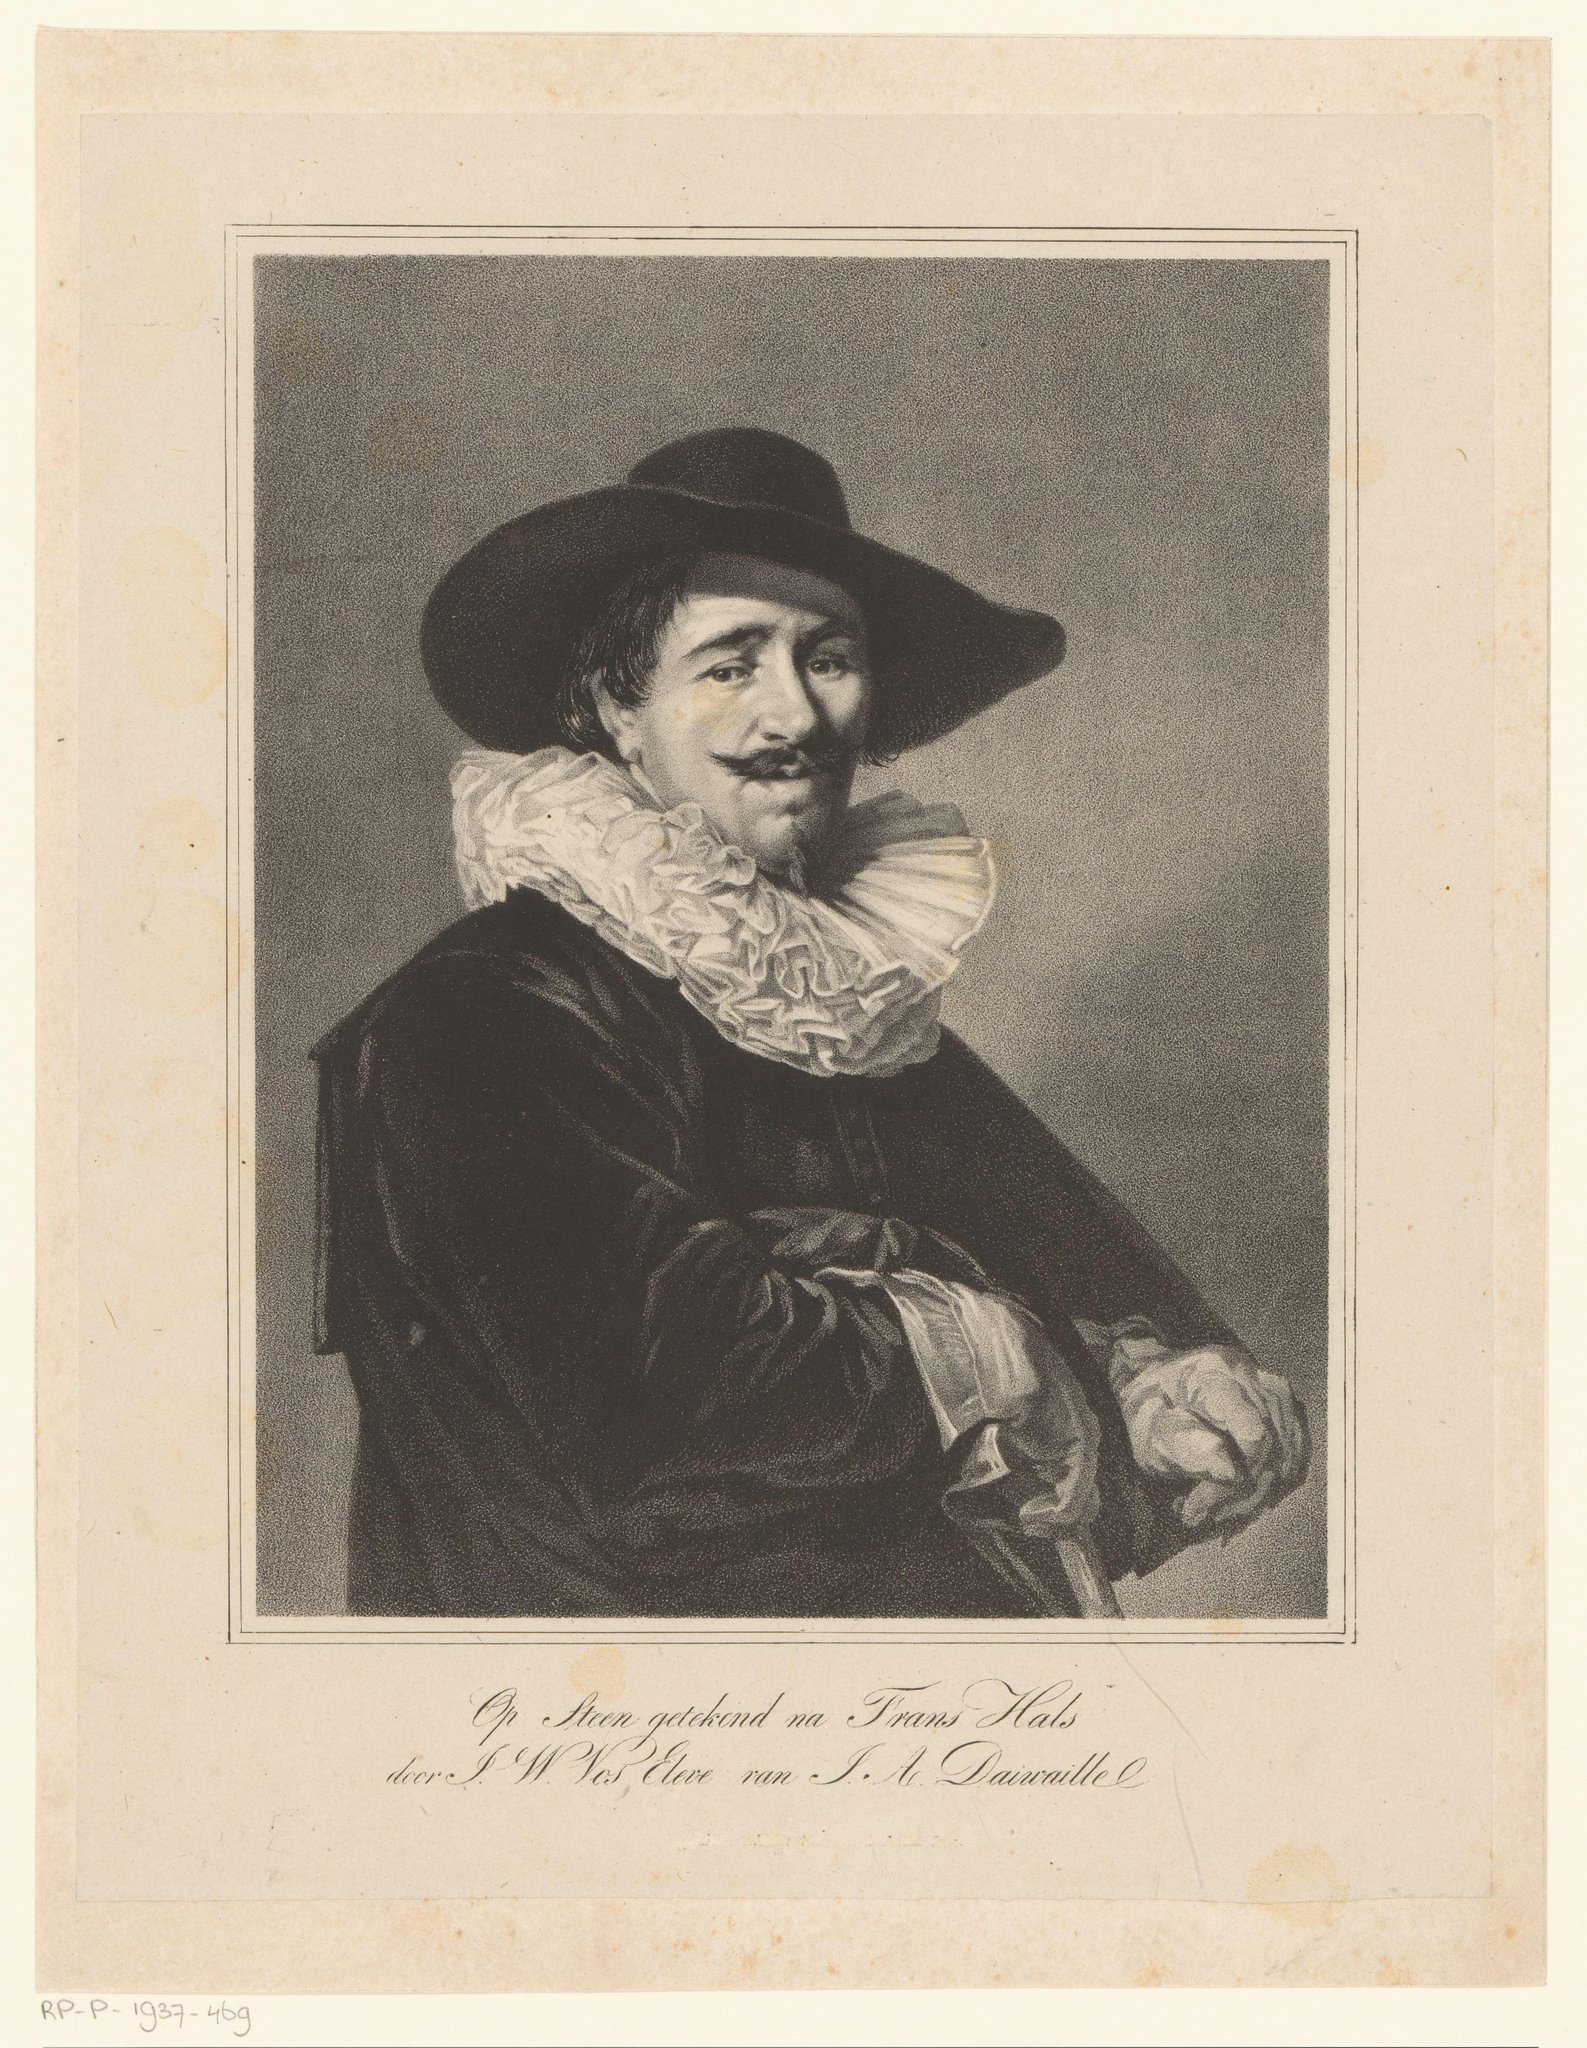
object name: print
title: Zelfportret van Frans Hals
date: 1816-1853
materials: paper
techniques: lithograph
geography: netherlands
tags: antwerp, haarlem, draughtsman, frans hals, historical persons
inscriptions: collector's mark: Lugt 2760, collector's mark: Lugt 2228